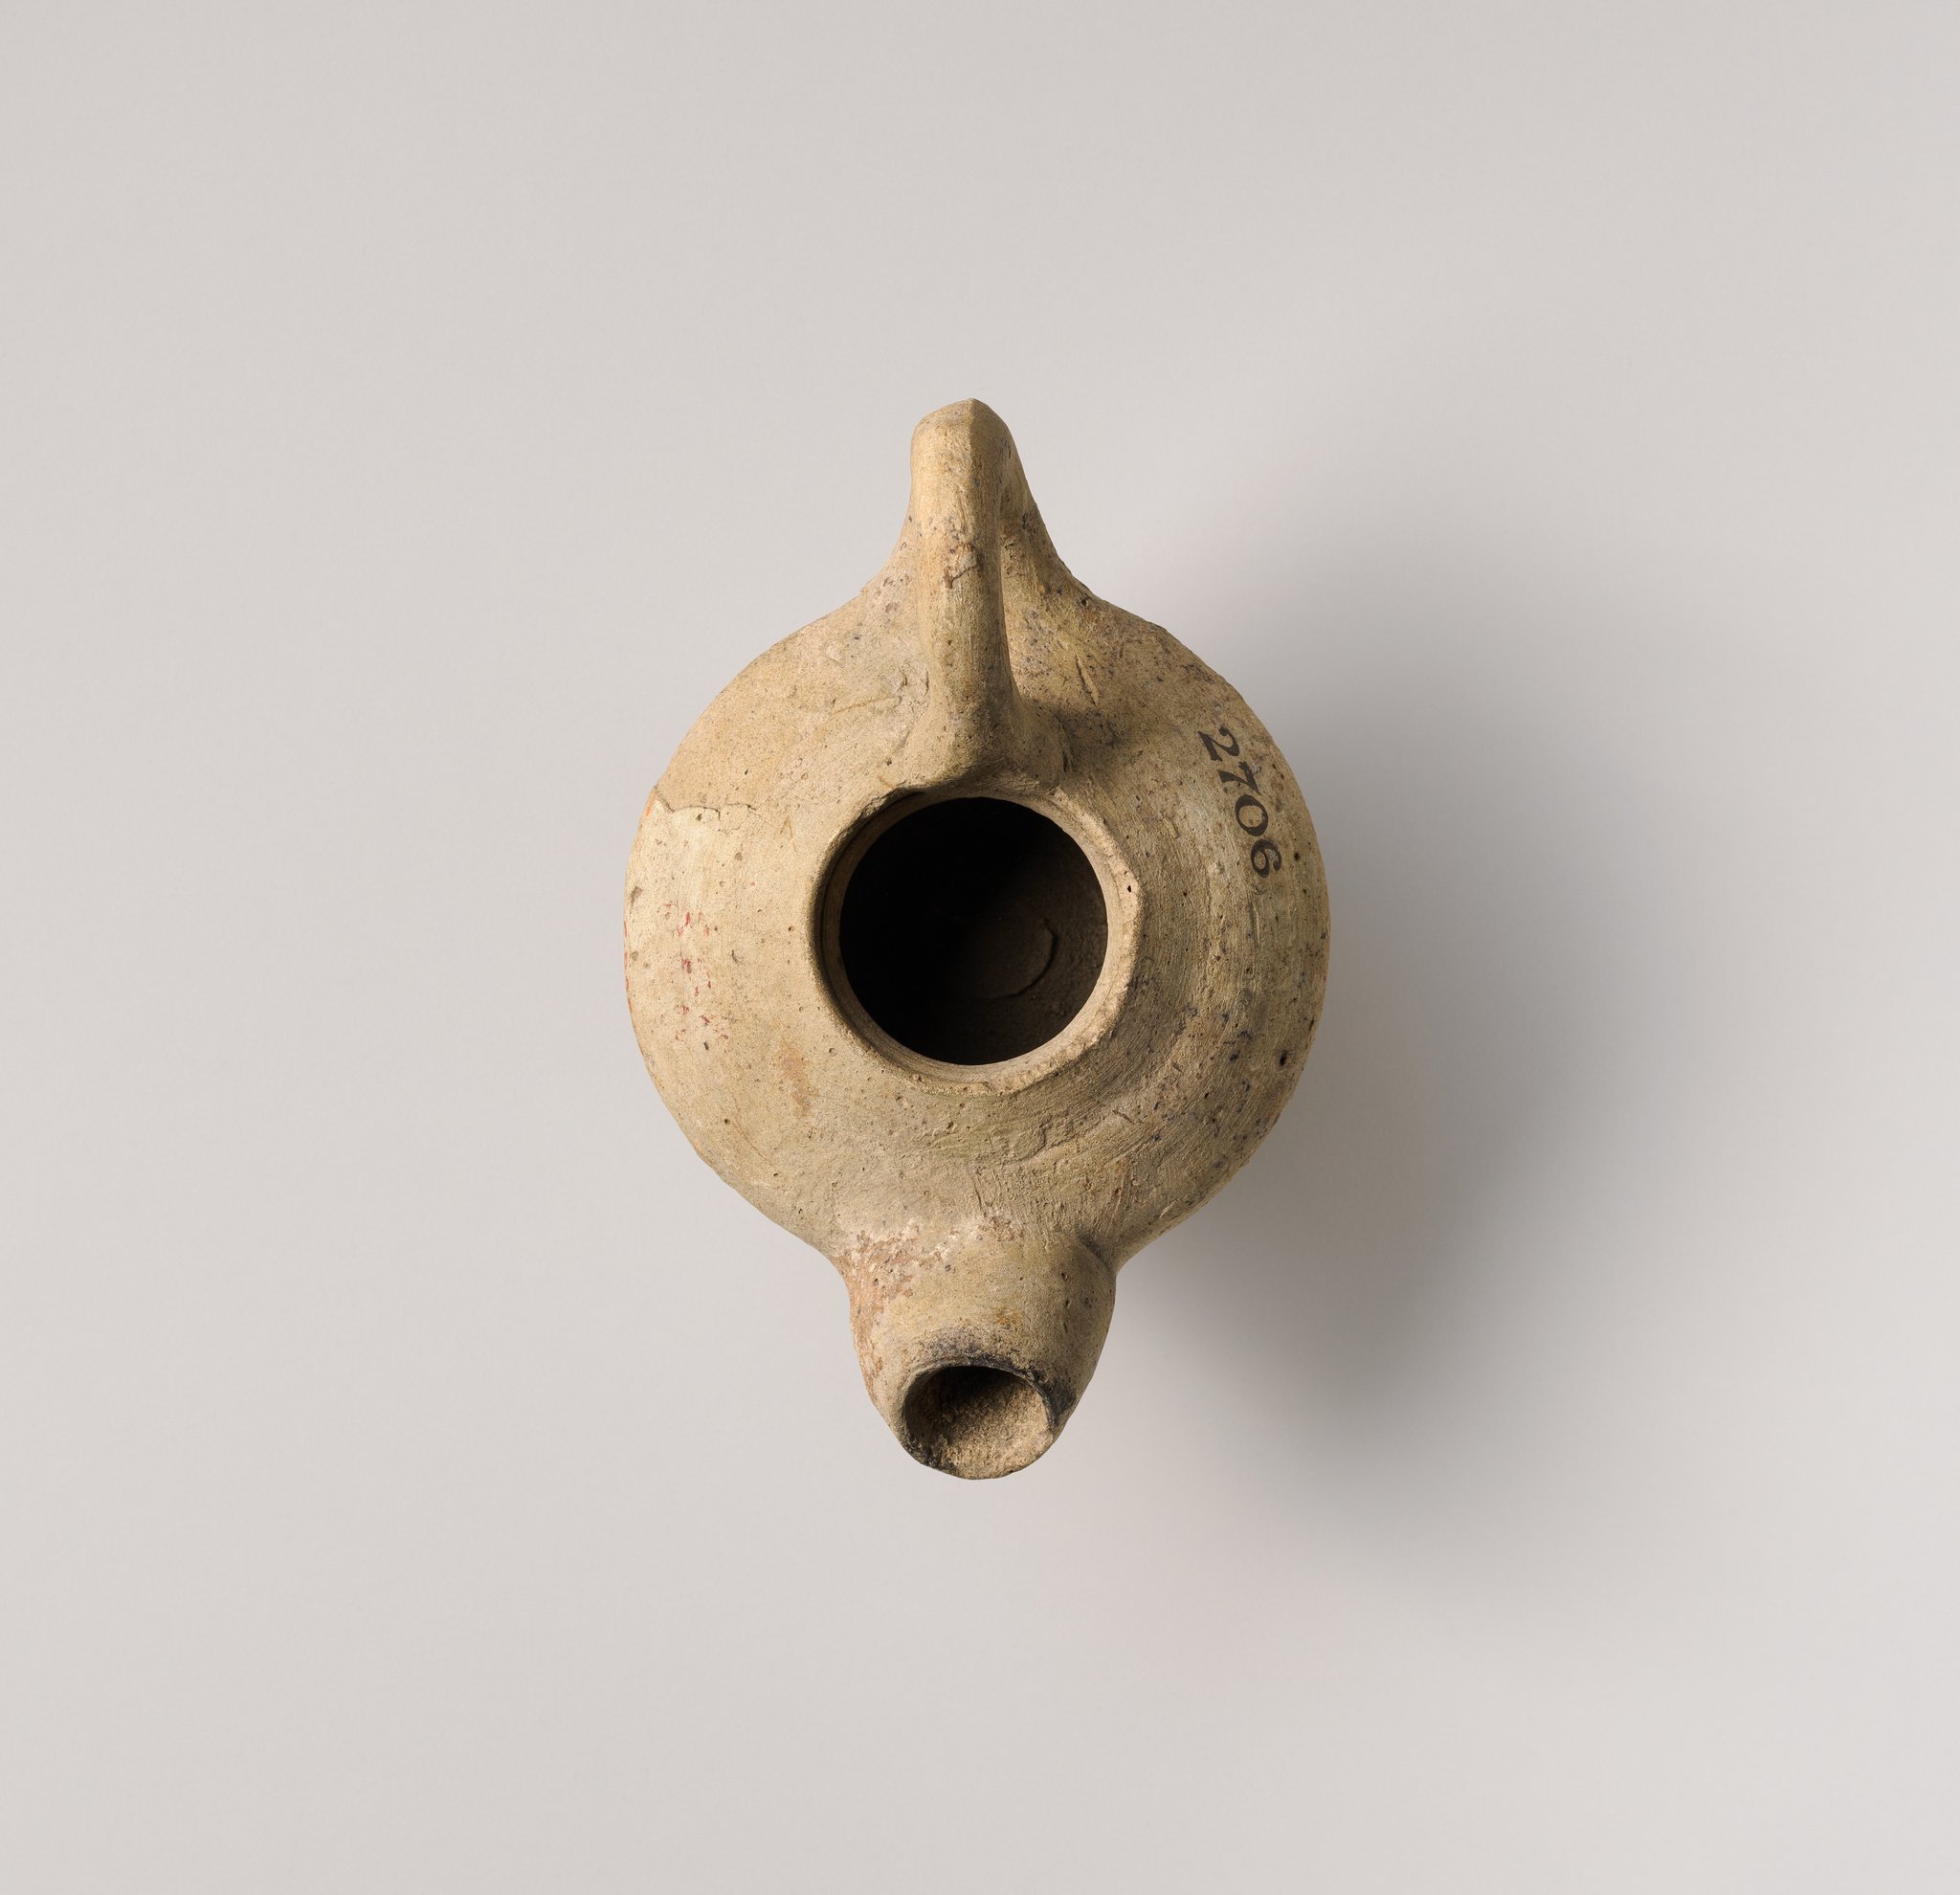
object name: lamp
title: Terracotta oil lamp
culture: roman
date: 401-700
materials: terracotta